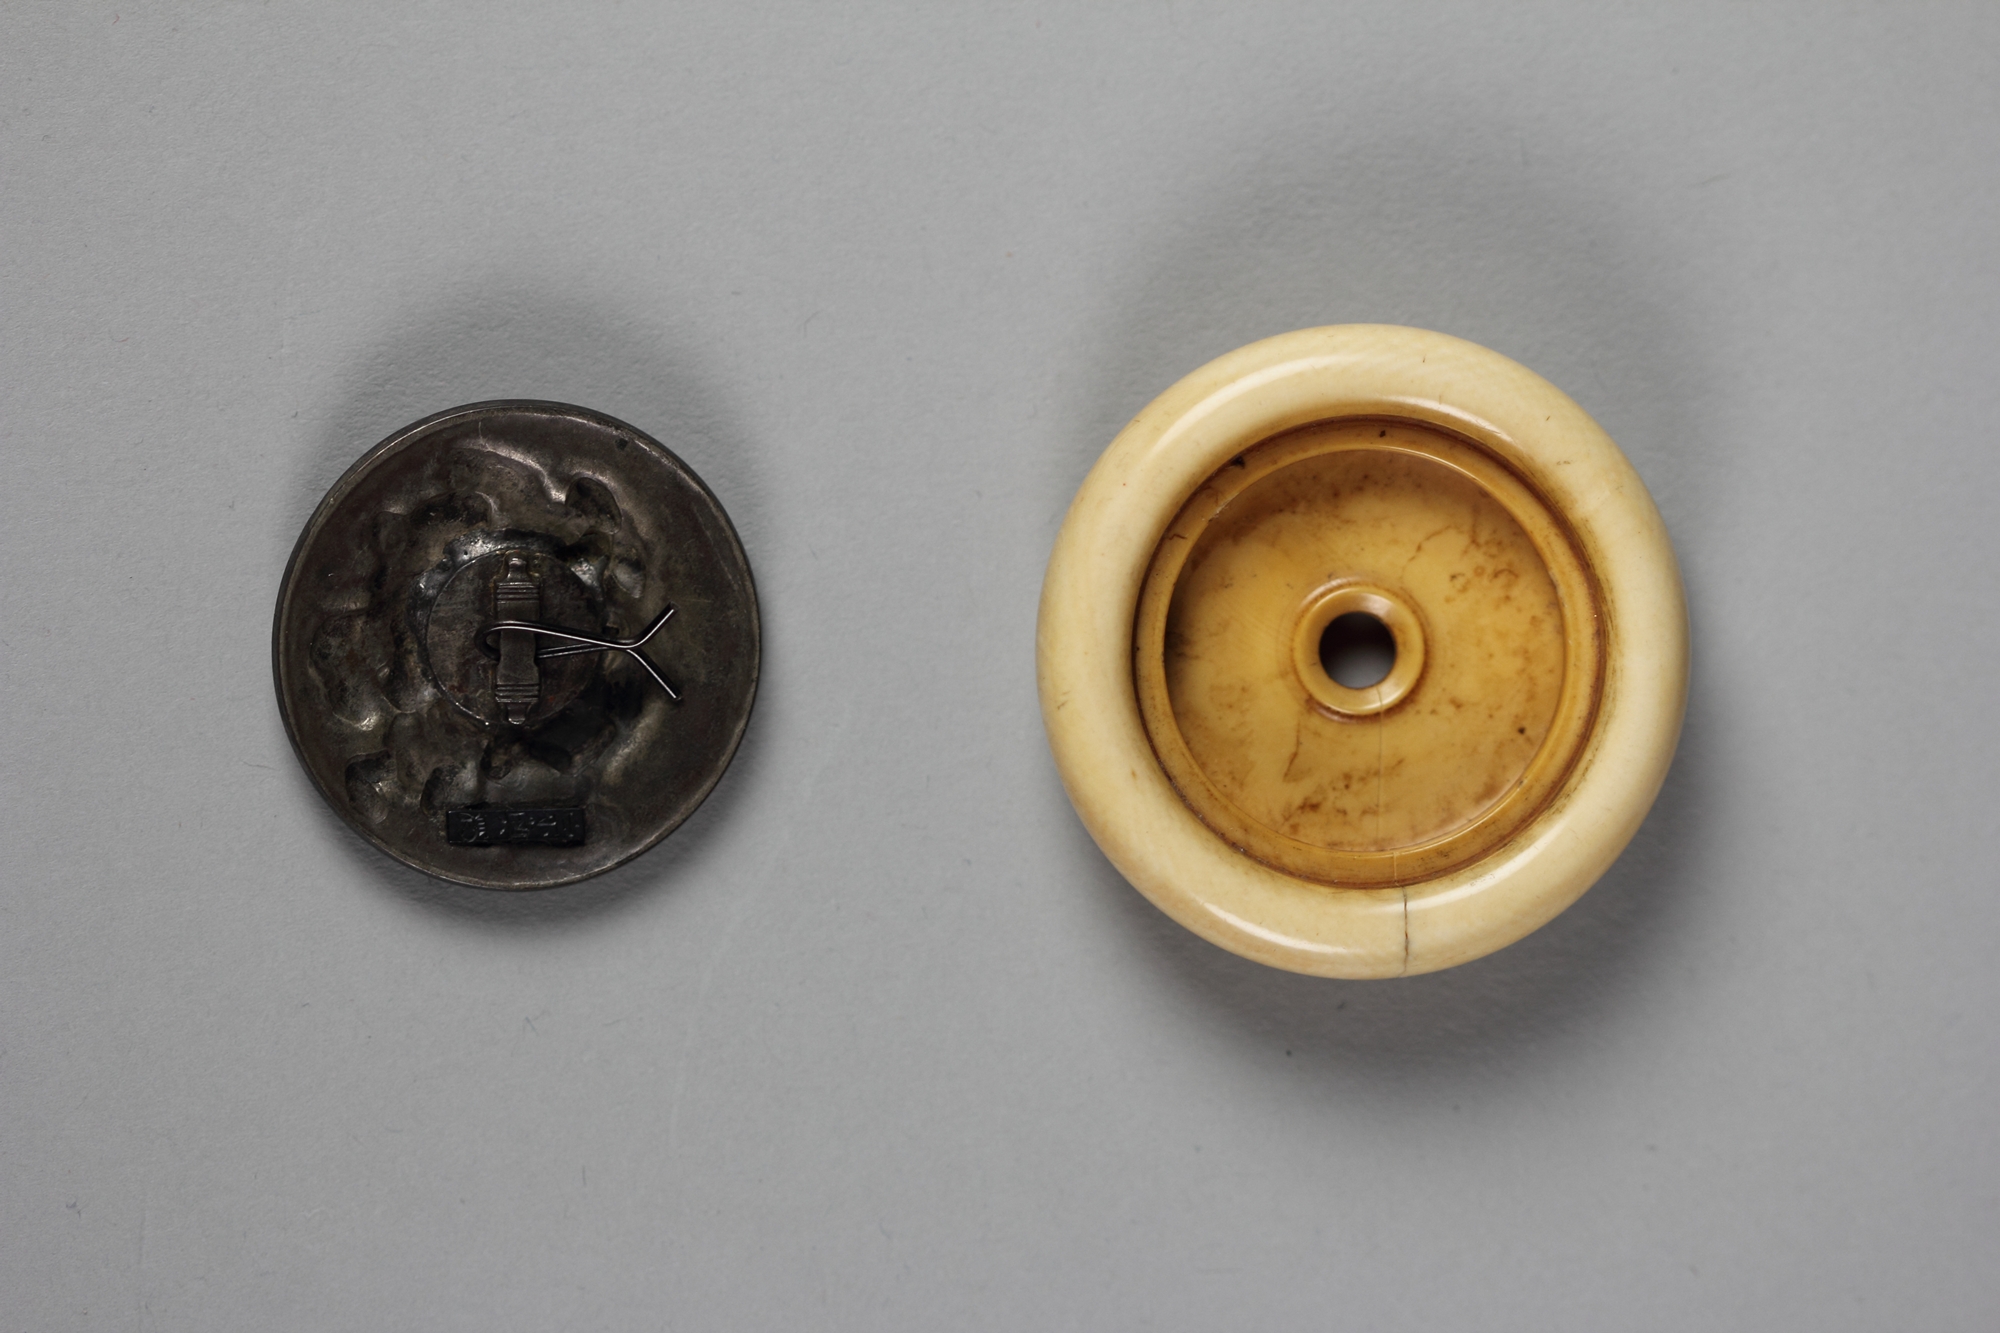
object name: netsuke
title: Netsuke of Daikoku and His Bag Dancing with a Man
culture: japanese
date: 1801-1900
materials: ivory, metal